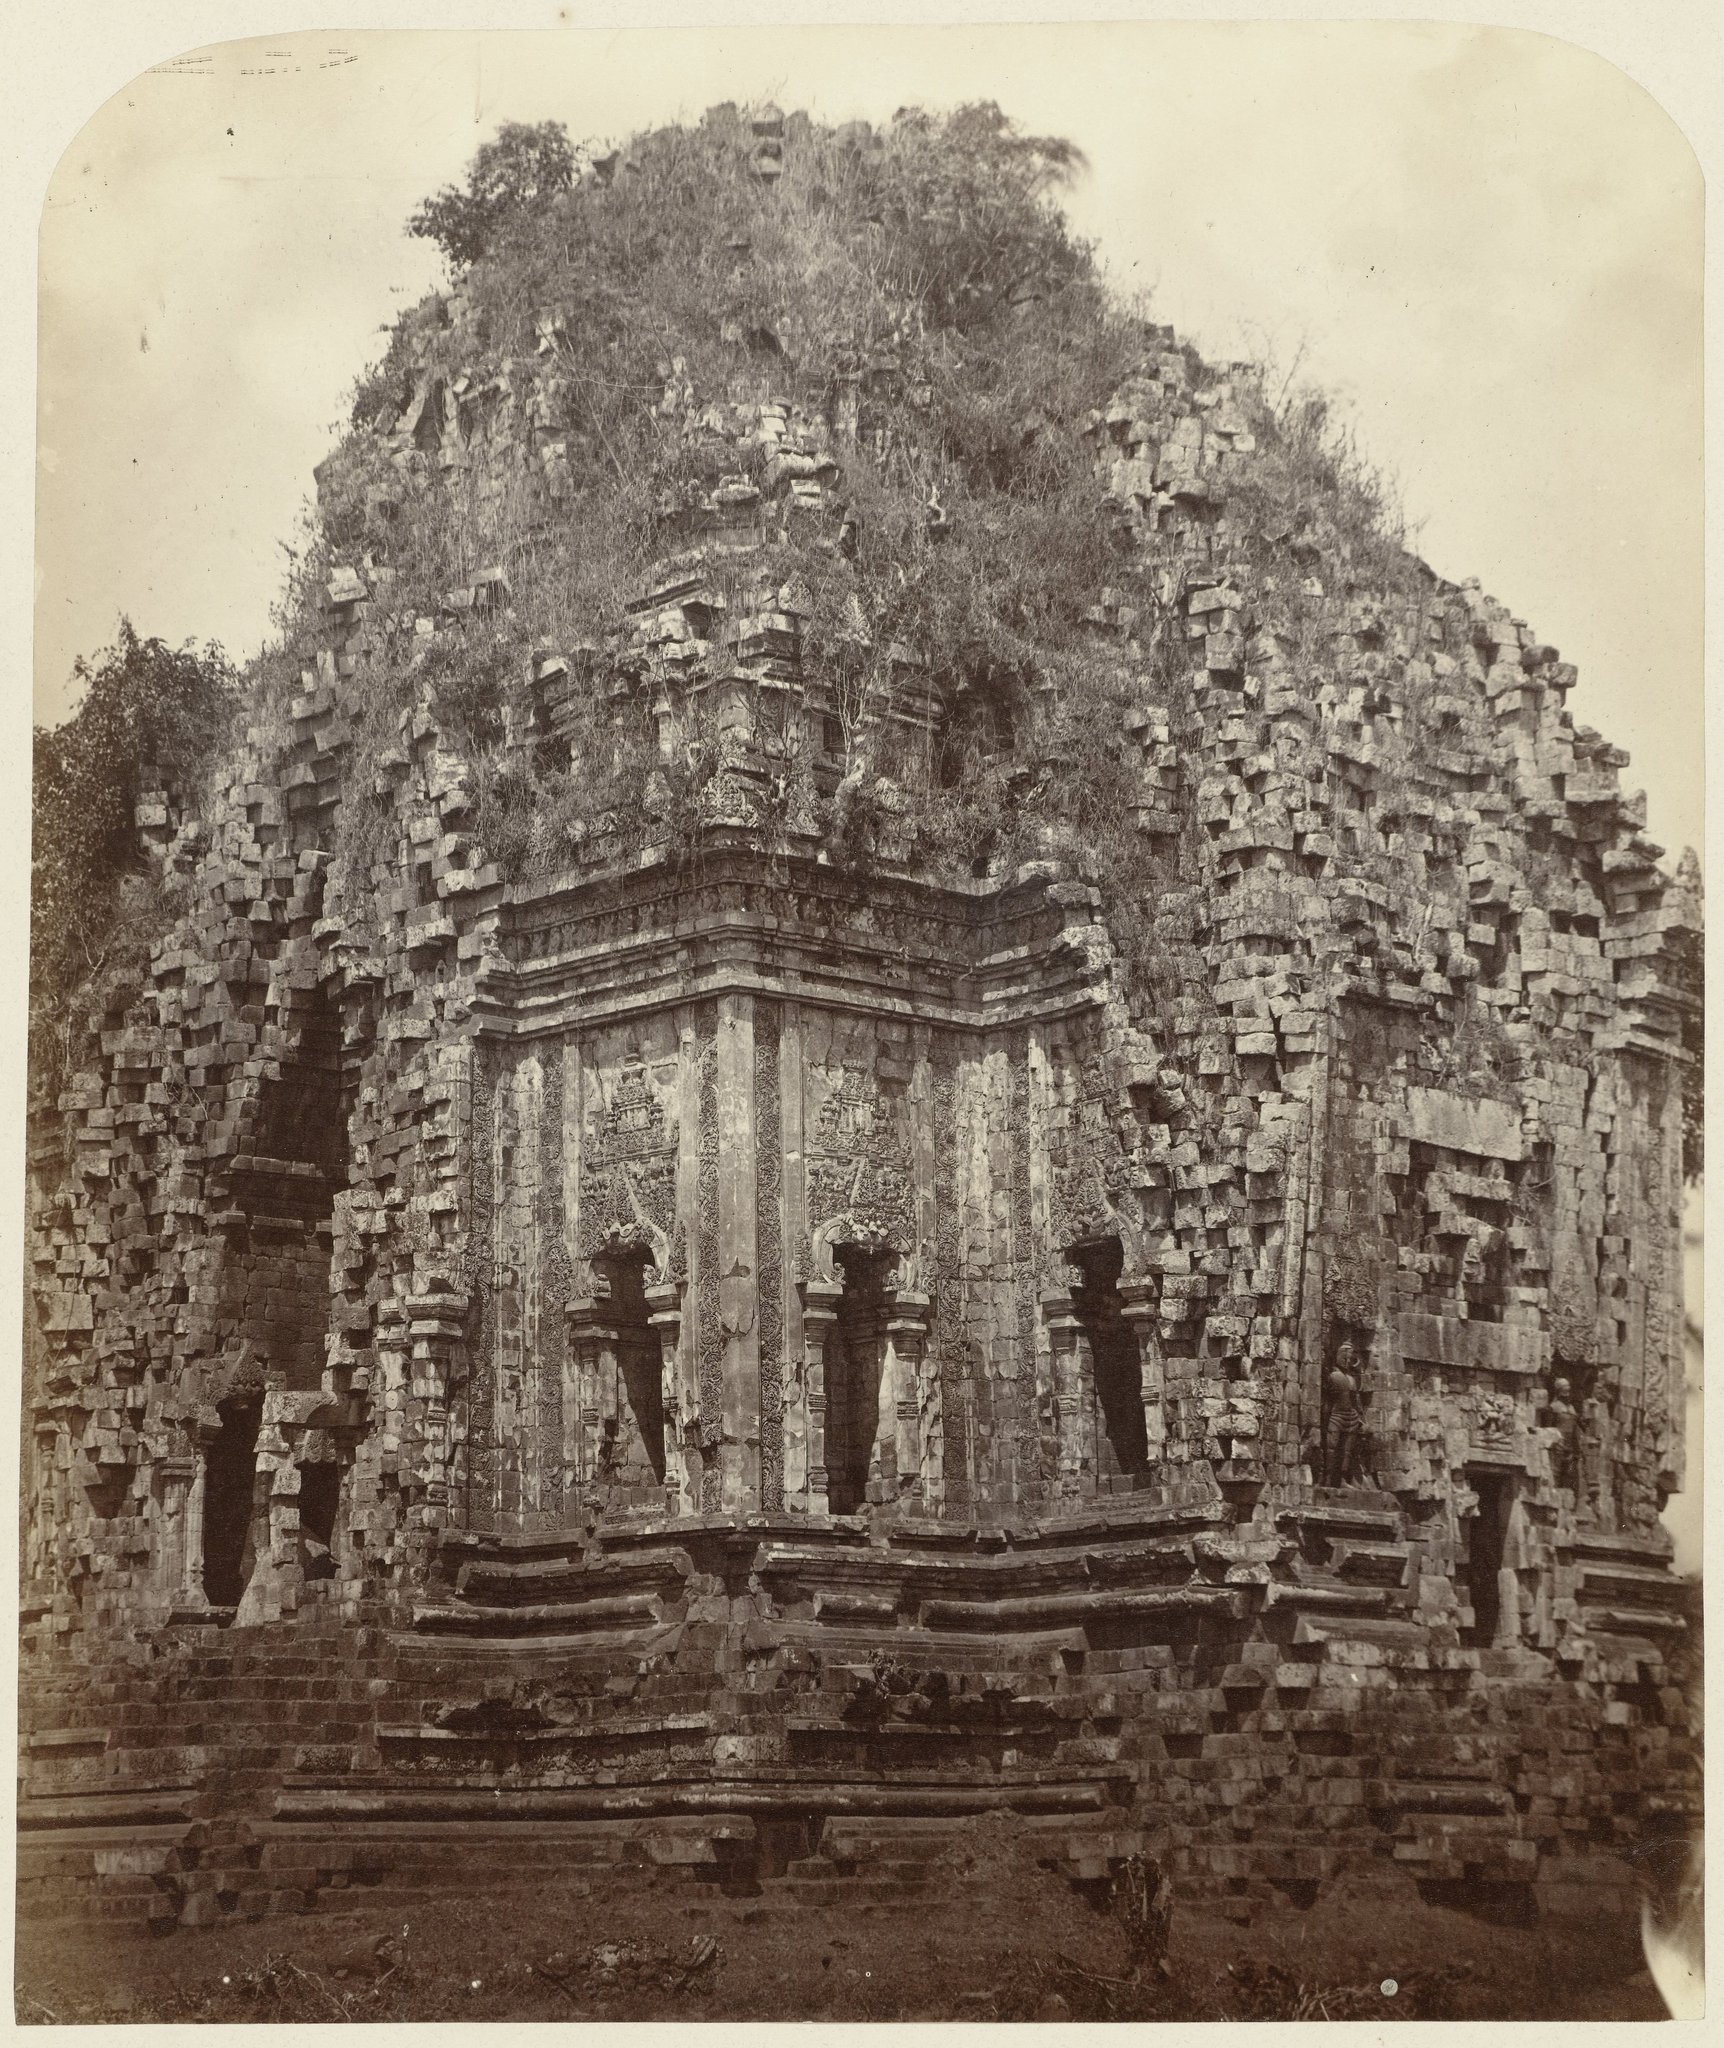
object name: photograph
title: Candi Kalasan (Buddhist), general view from the northeast. Kalasan, Yogyakarta district, D.I. Yogyakarta province, 8th -9th century.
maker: isidore kinsbergen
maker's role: fotograaf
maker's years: 1821-1905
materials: cardboard, paper, photographic support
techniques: albumen print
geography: java